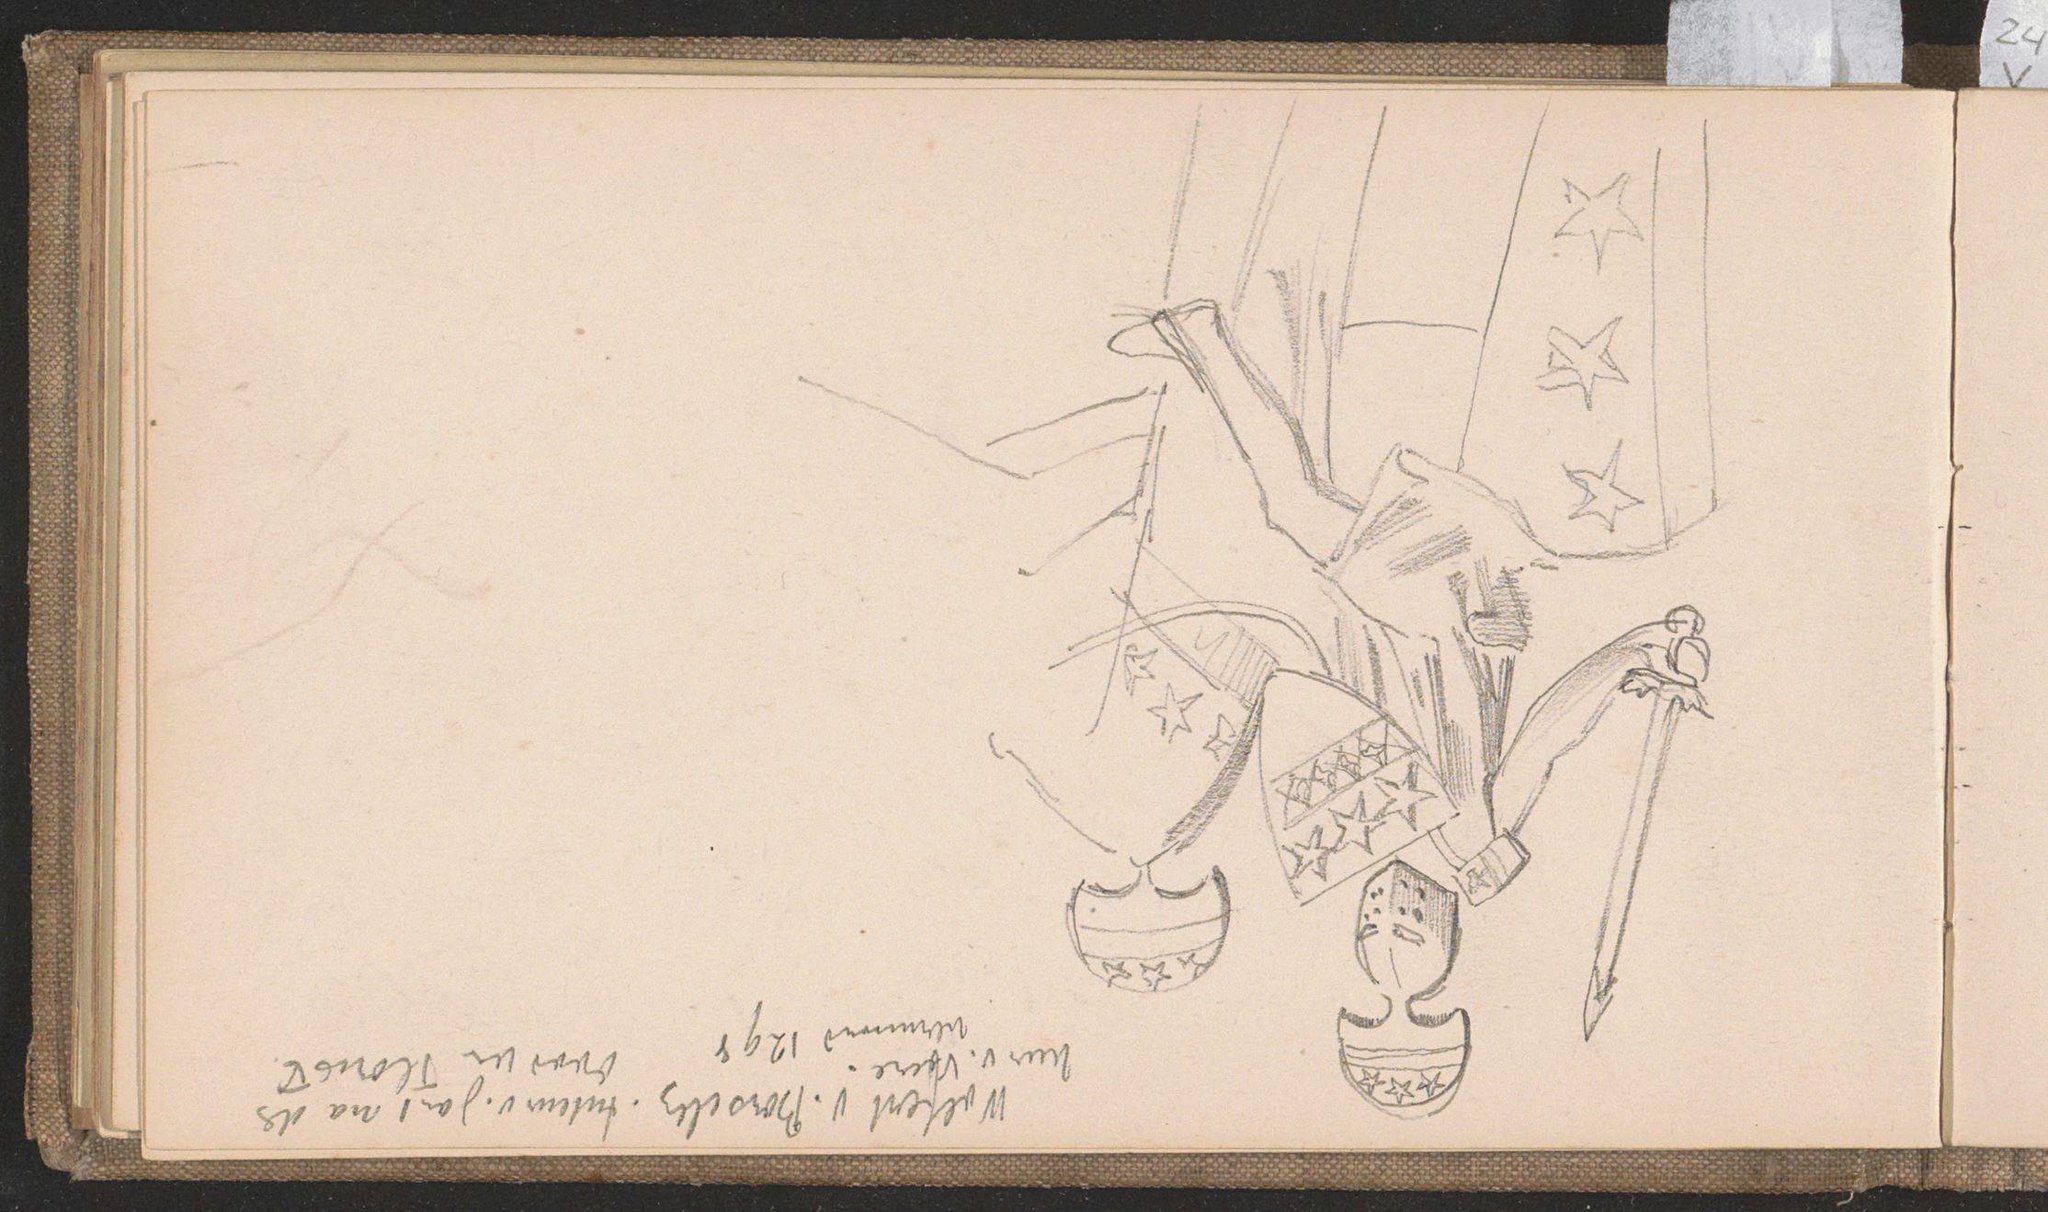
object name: sketchbook leaf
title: Wolfert I van Borselen te paard in wapenrusting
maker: antoon derkinderen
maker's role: draughtsman, painter, print maker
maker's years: 1859-1925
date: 1892-1901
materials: paper, pencil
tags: delft, armour, historical persons (portraits and scenes from the life)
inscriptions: annotation: ‘Wolfert v. Borsele/ heer c. Veere./ vermoord 1294/ tu[...] v. Jan I na d[...]/ [...] Floris V’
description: Blad 19 verso uit een schetsboek met 51 bladen.